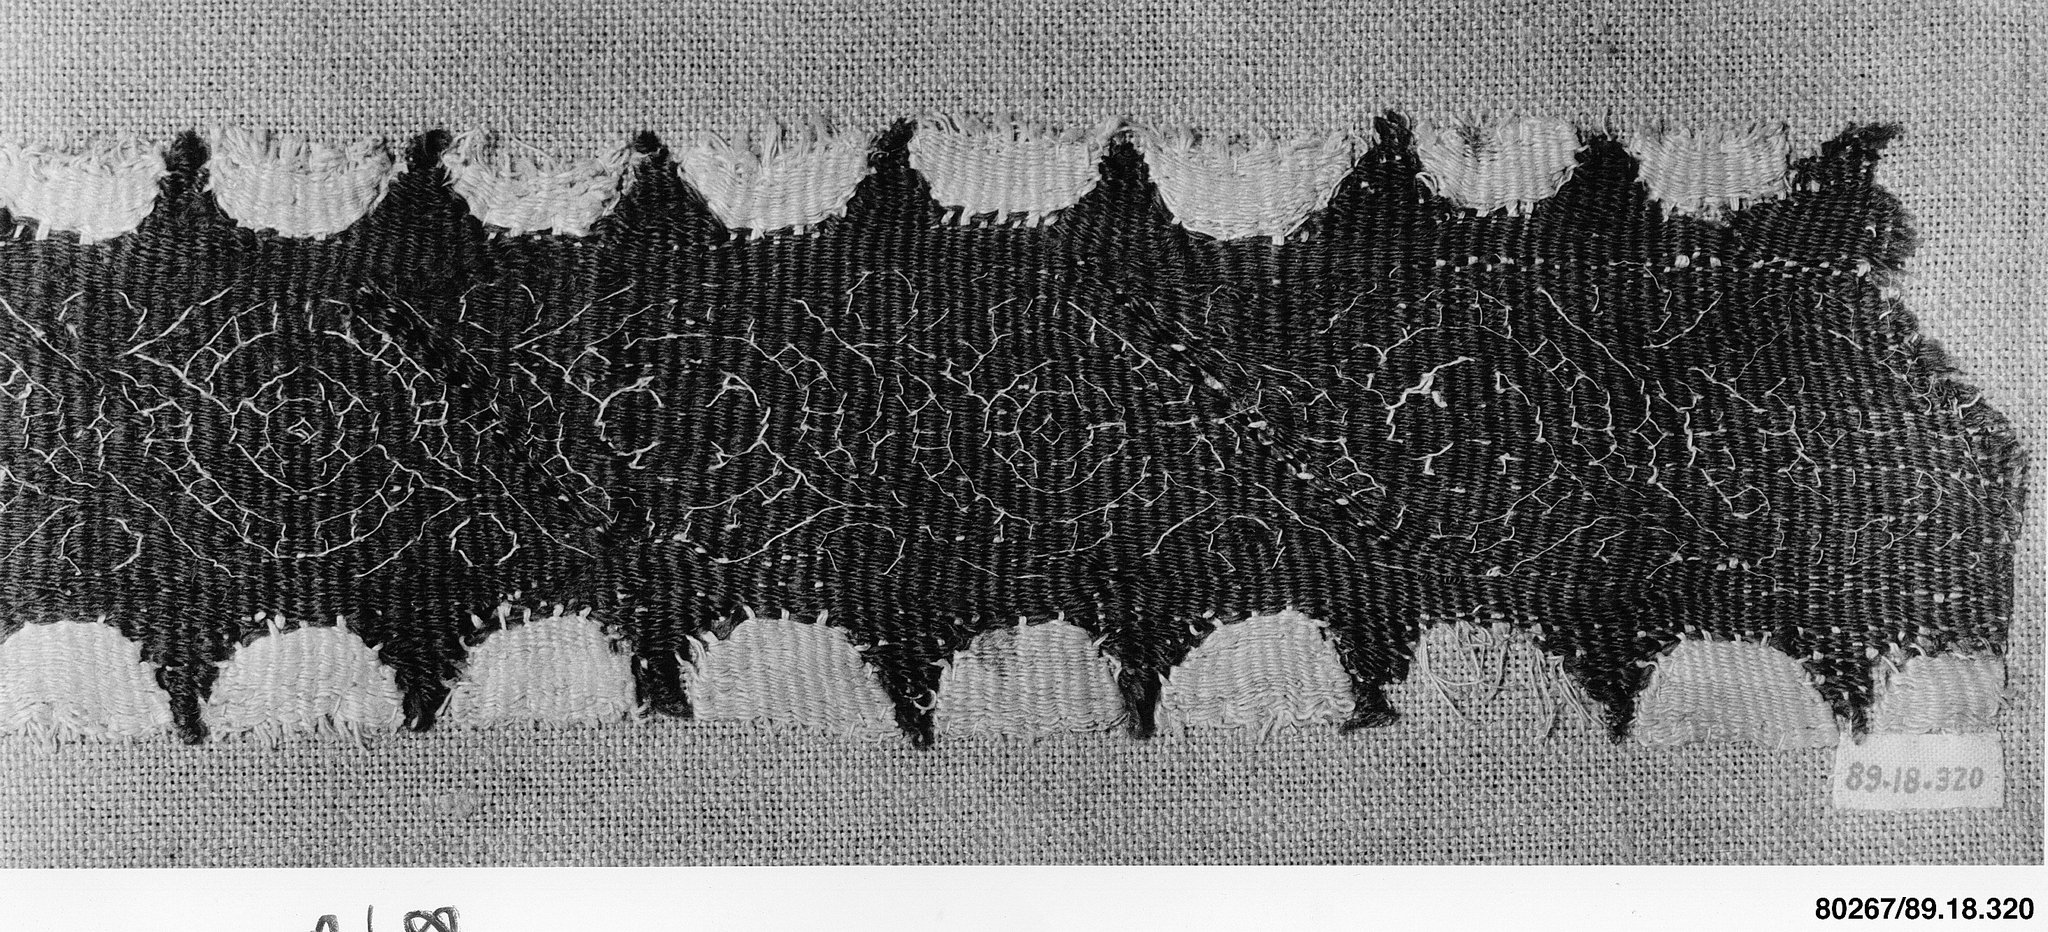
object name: textile fragment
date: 201-400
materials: linen, wool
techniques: weave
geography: egypt